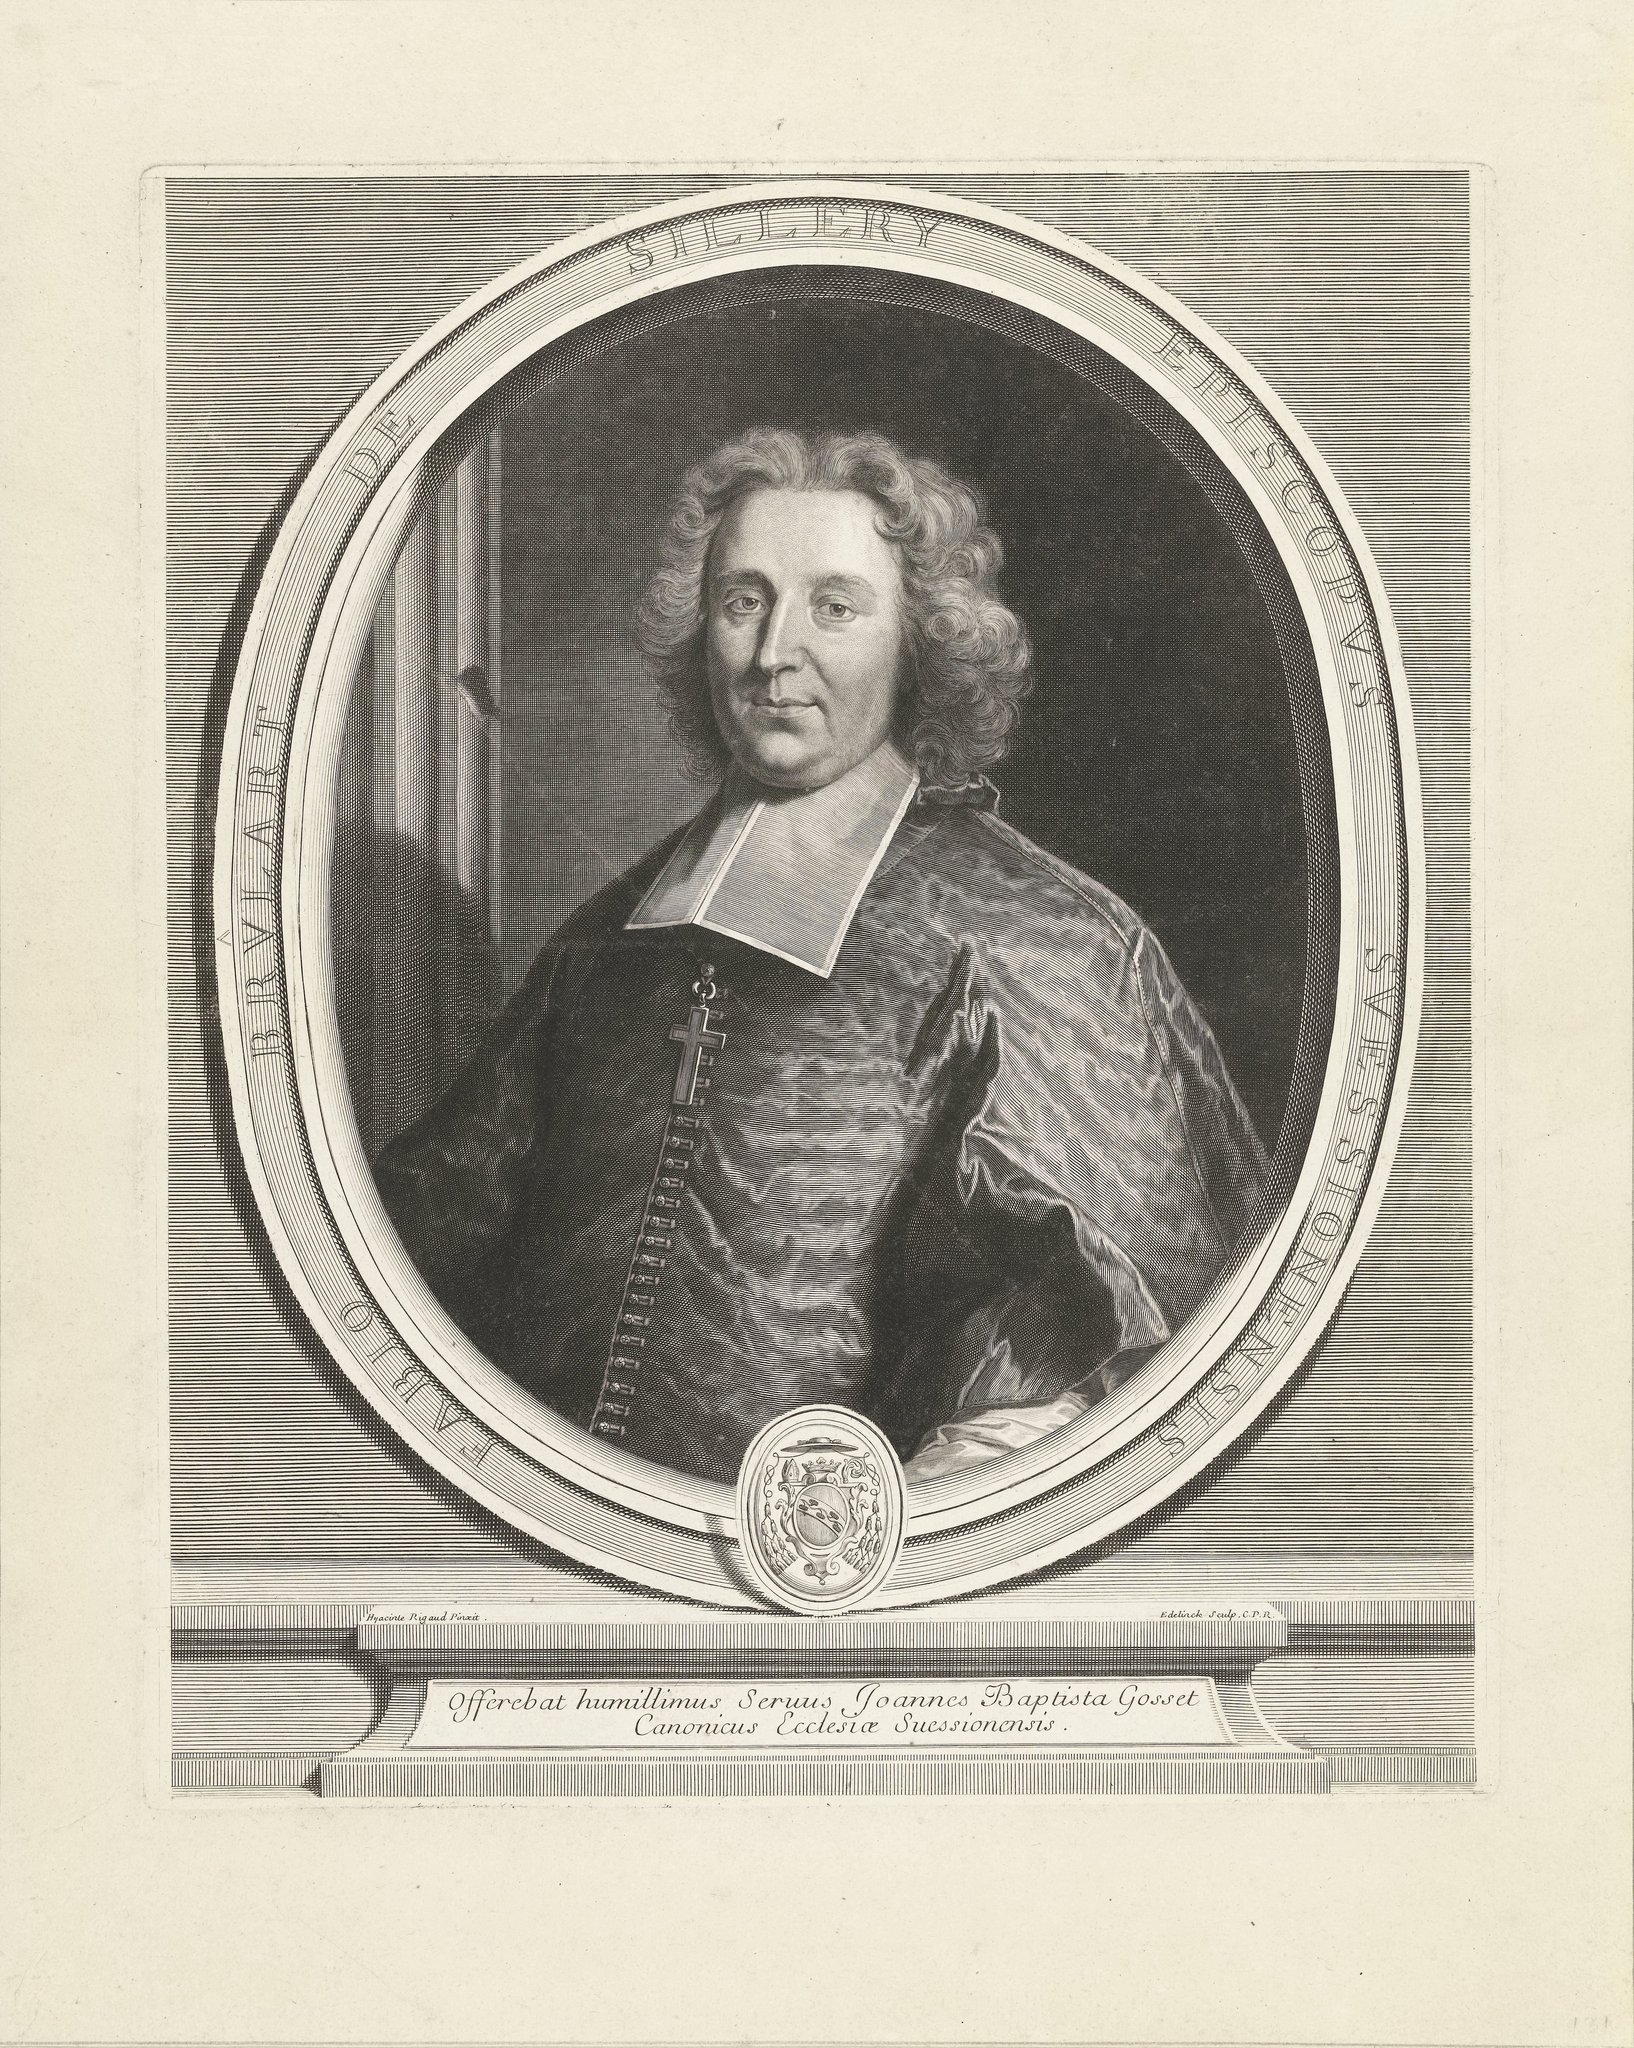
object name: print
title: Portret van Fabio Brûlart de Sillery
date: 1698-1707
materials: paper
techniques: engraving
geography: france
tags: france, paris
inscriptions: collector's mark: Lugt 240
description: Portret van Fabio Brûlart de Sillery (1655-1714), bisschop van Avraches en Soissons, afgebeeld tegen een pilaster en in een ovale omlijsting met wapen. Onder het wapen twee regels Latijn.